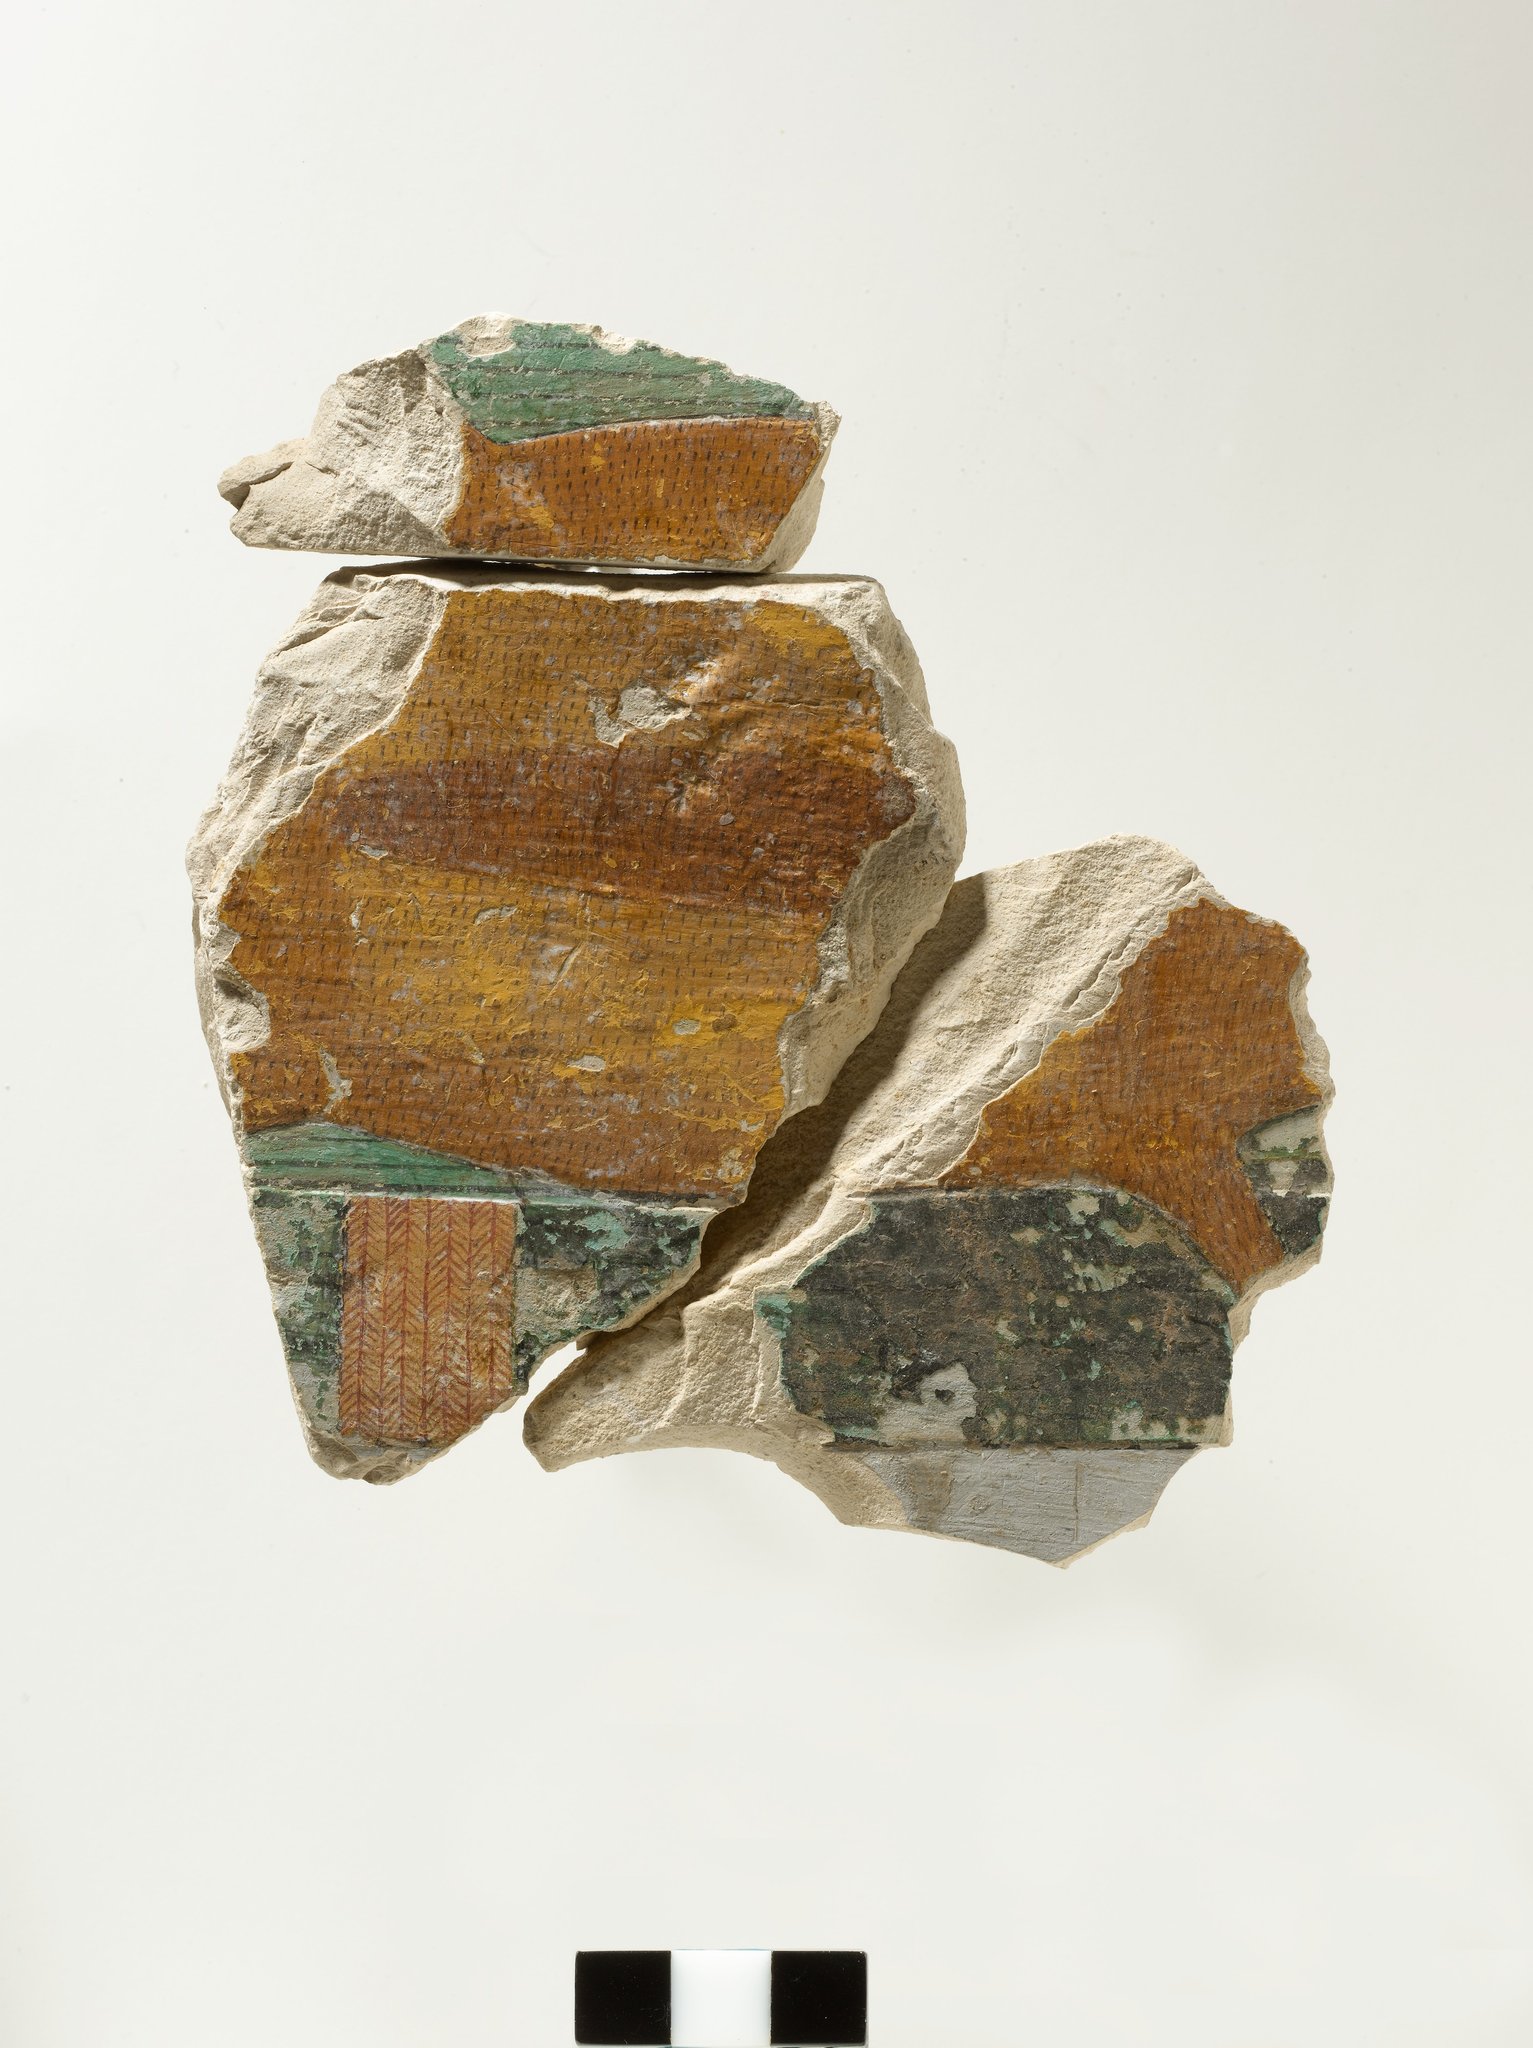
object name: relief fragment, tomb of meketre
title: Relief fragment from the tomb of Meketre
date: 1981-1975 BCE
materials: limestone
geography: egypt